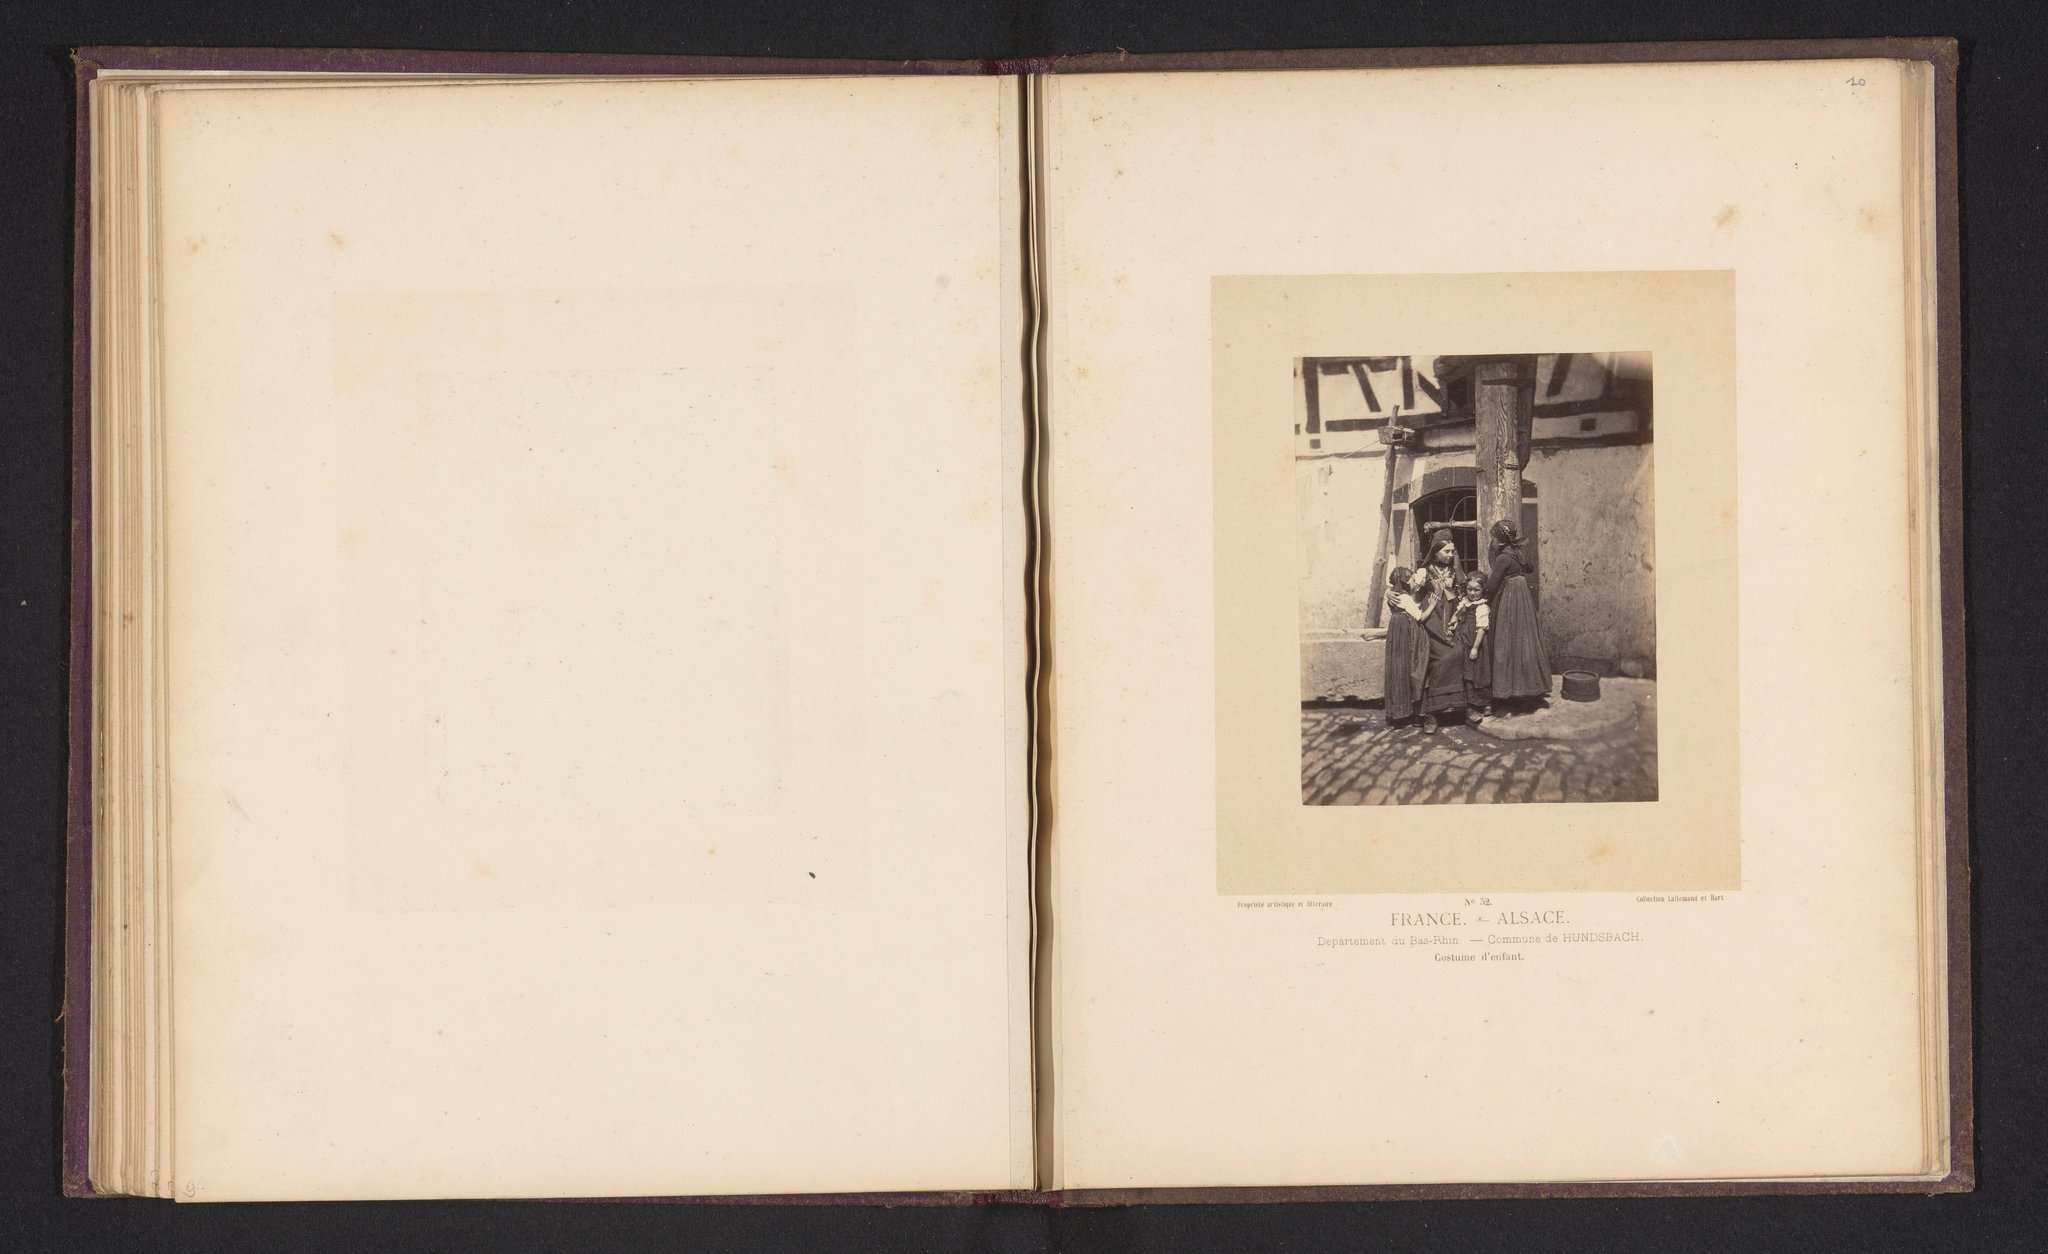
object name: photograph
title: Costume d'enfant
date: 1855-1865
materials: photographic support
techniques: albumen print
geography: hundsbach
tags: girl (child between toddler and youth), folk costume, regional costume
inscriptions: number: ‘10’, number: ‘No. 52.’, inscription: ‘France. Alsace. Departement du Bas-Rhin.- Commune de Hundsbach’